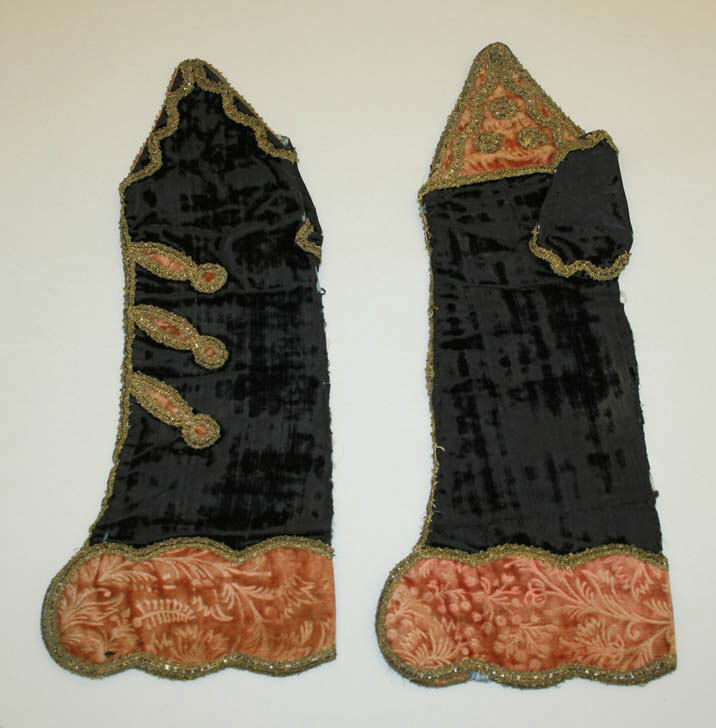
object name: mitt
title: Mitts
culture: european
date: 1701-1800